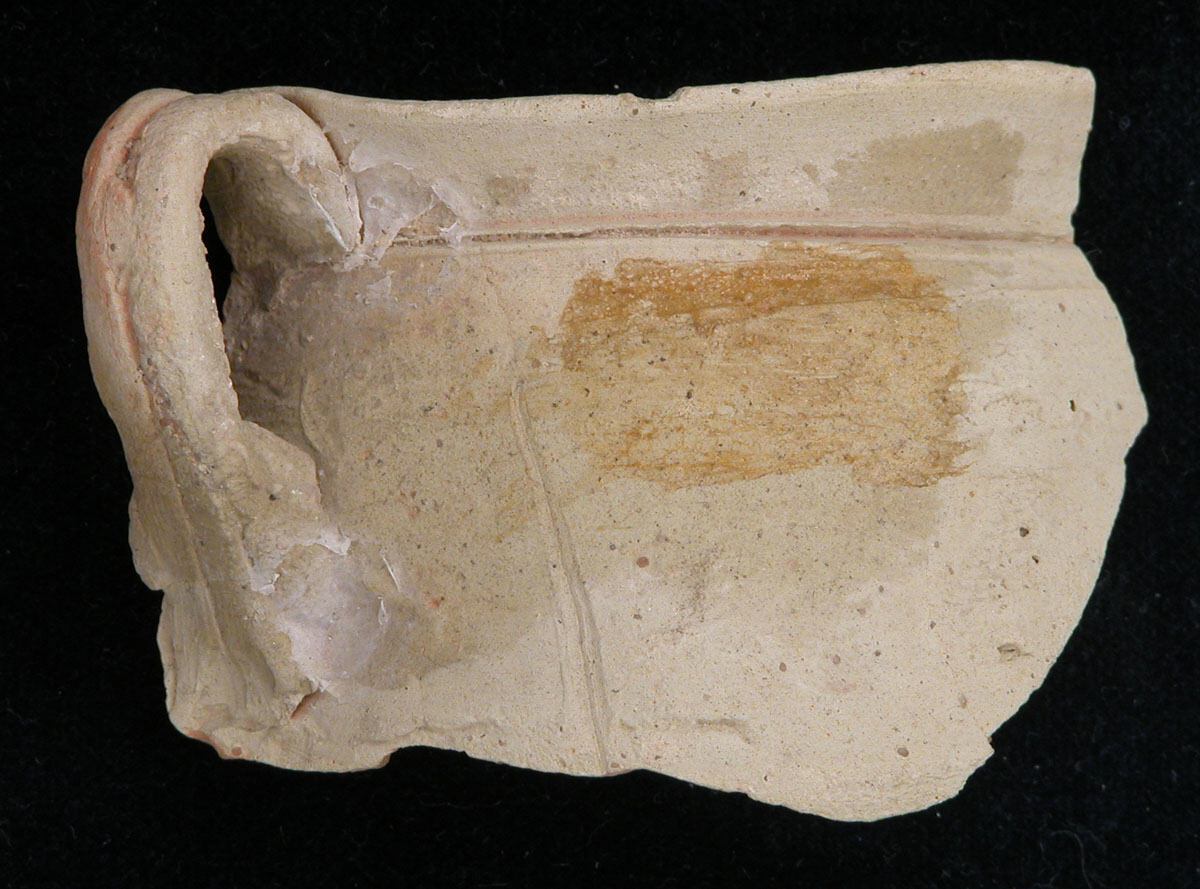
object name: fragment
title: Fragment of a Cup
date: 801-1000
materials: earthenware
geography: saudi arabia